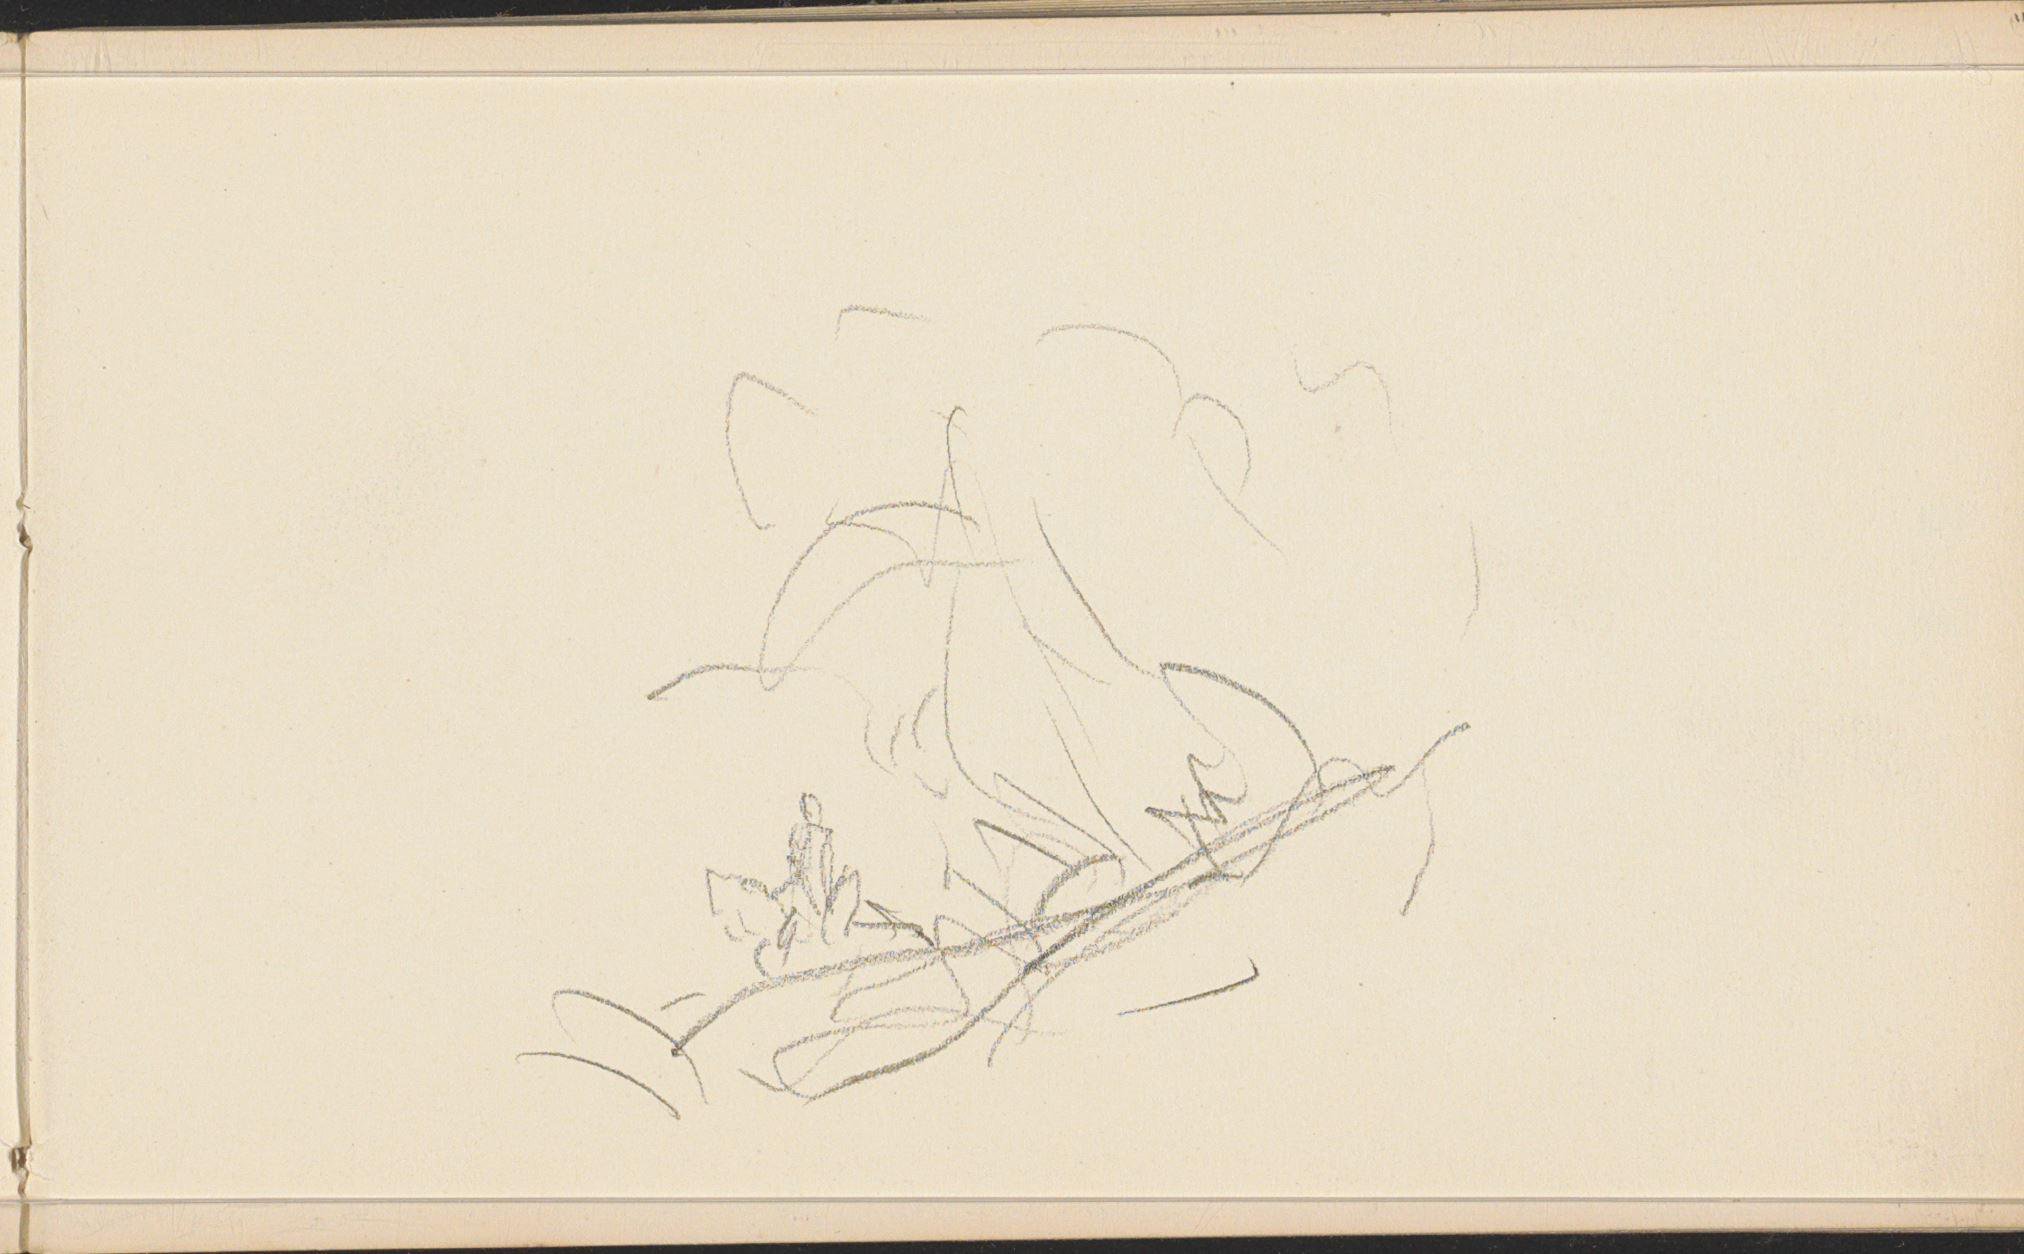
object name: sketchbook leaf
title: Ruiter op een weg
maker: marius bauer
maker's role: draughtsman, print maker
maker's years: 1867-1932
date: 1922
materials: paper, pencil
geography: algeria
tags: riding a horse, ass, or mule; rider, horseman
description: De figuur rijdt mogelijk op een ezel of paard. Pagina 11 uit een schetsboek met 31 bladen.